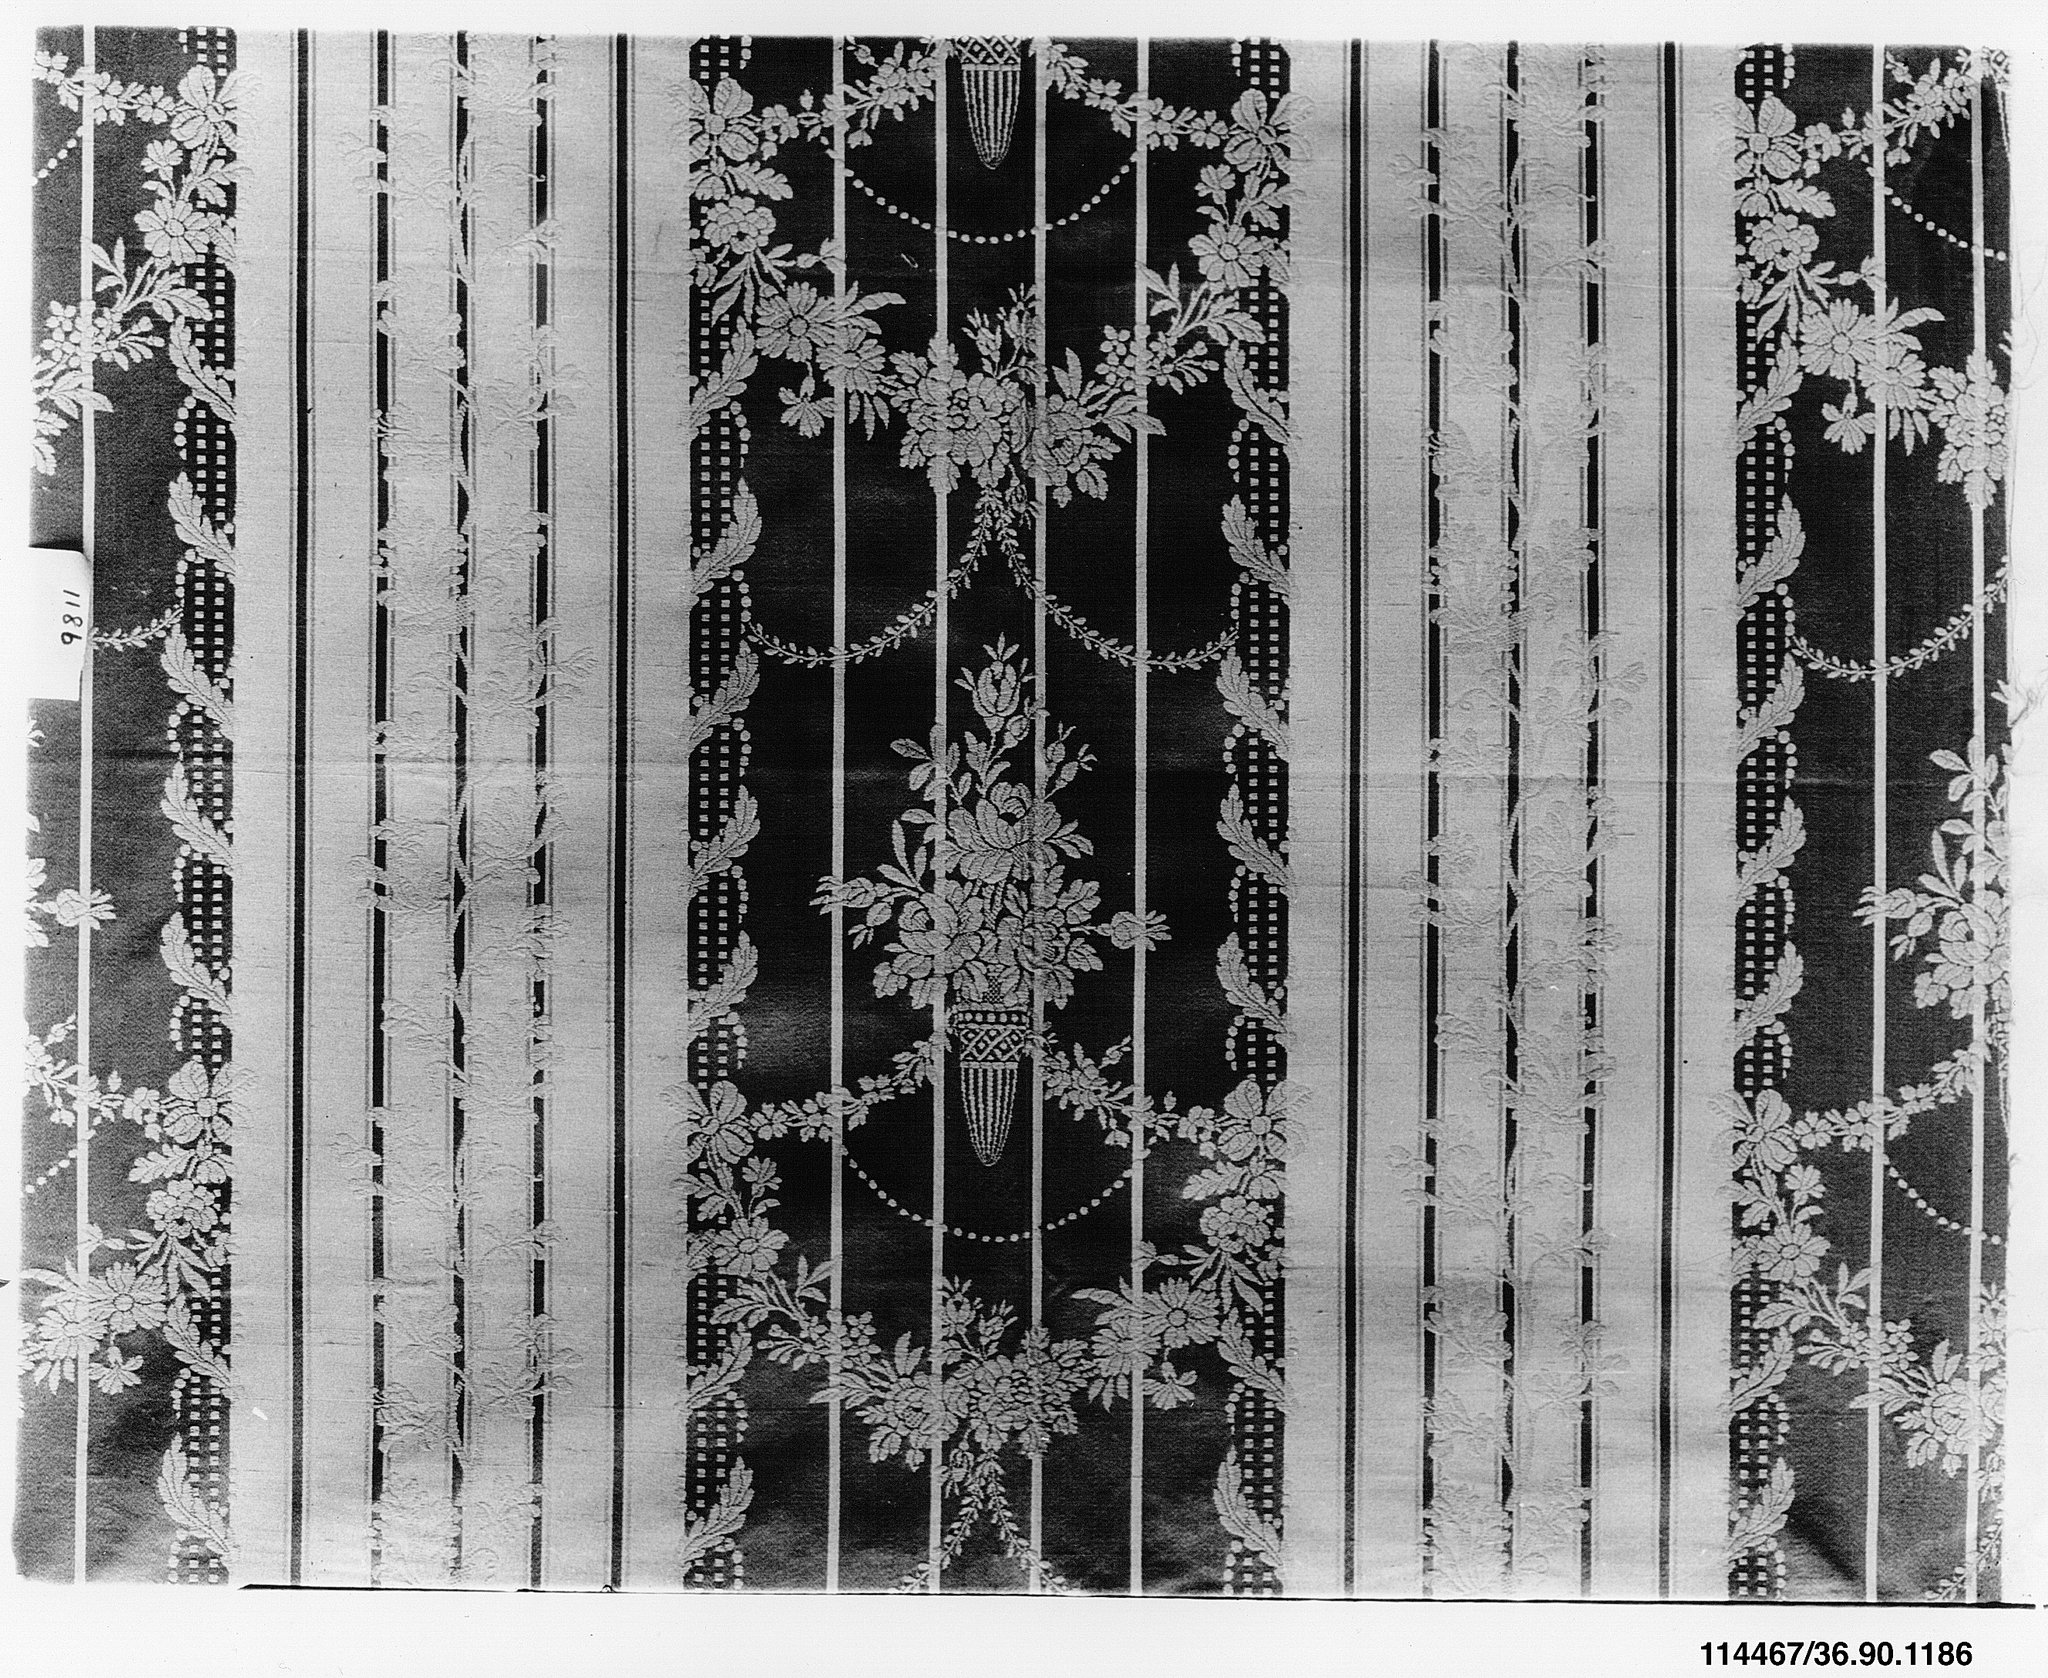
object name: piece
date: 1801-1900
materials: silk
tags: flowers,leaves